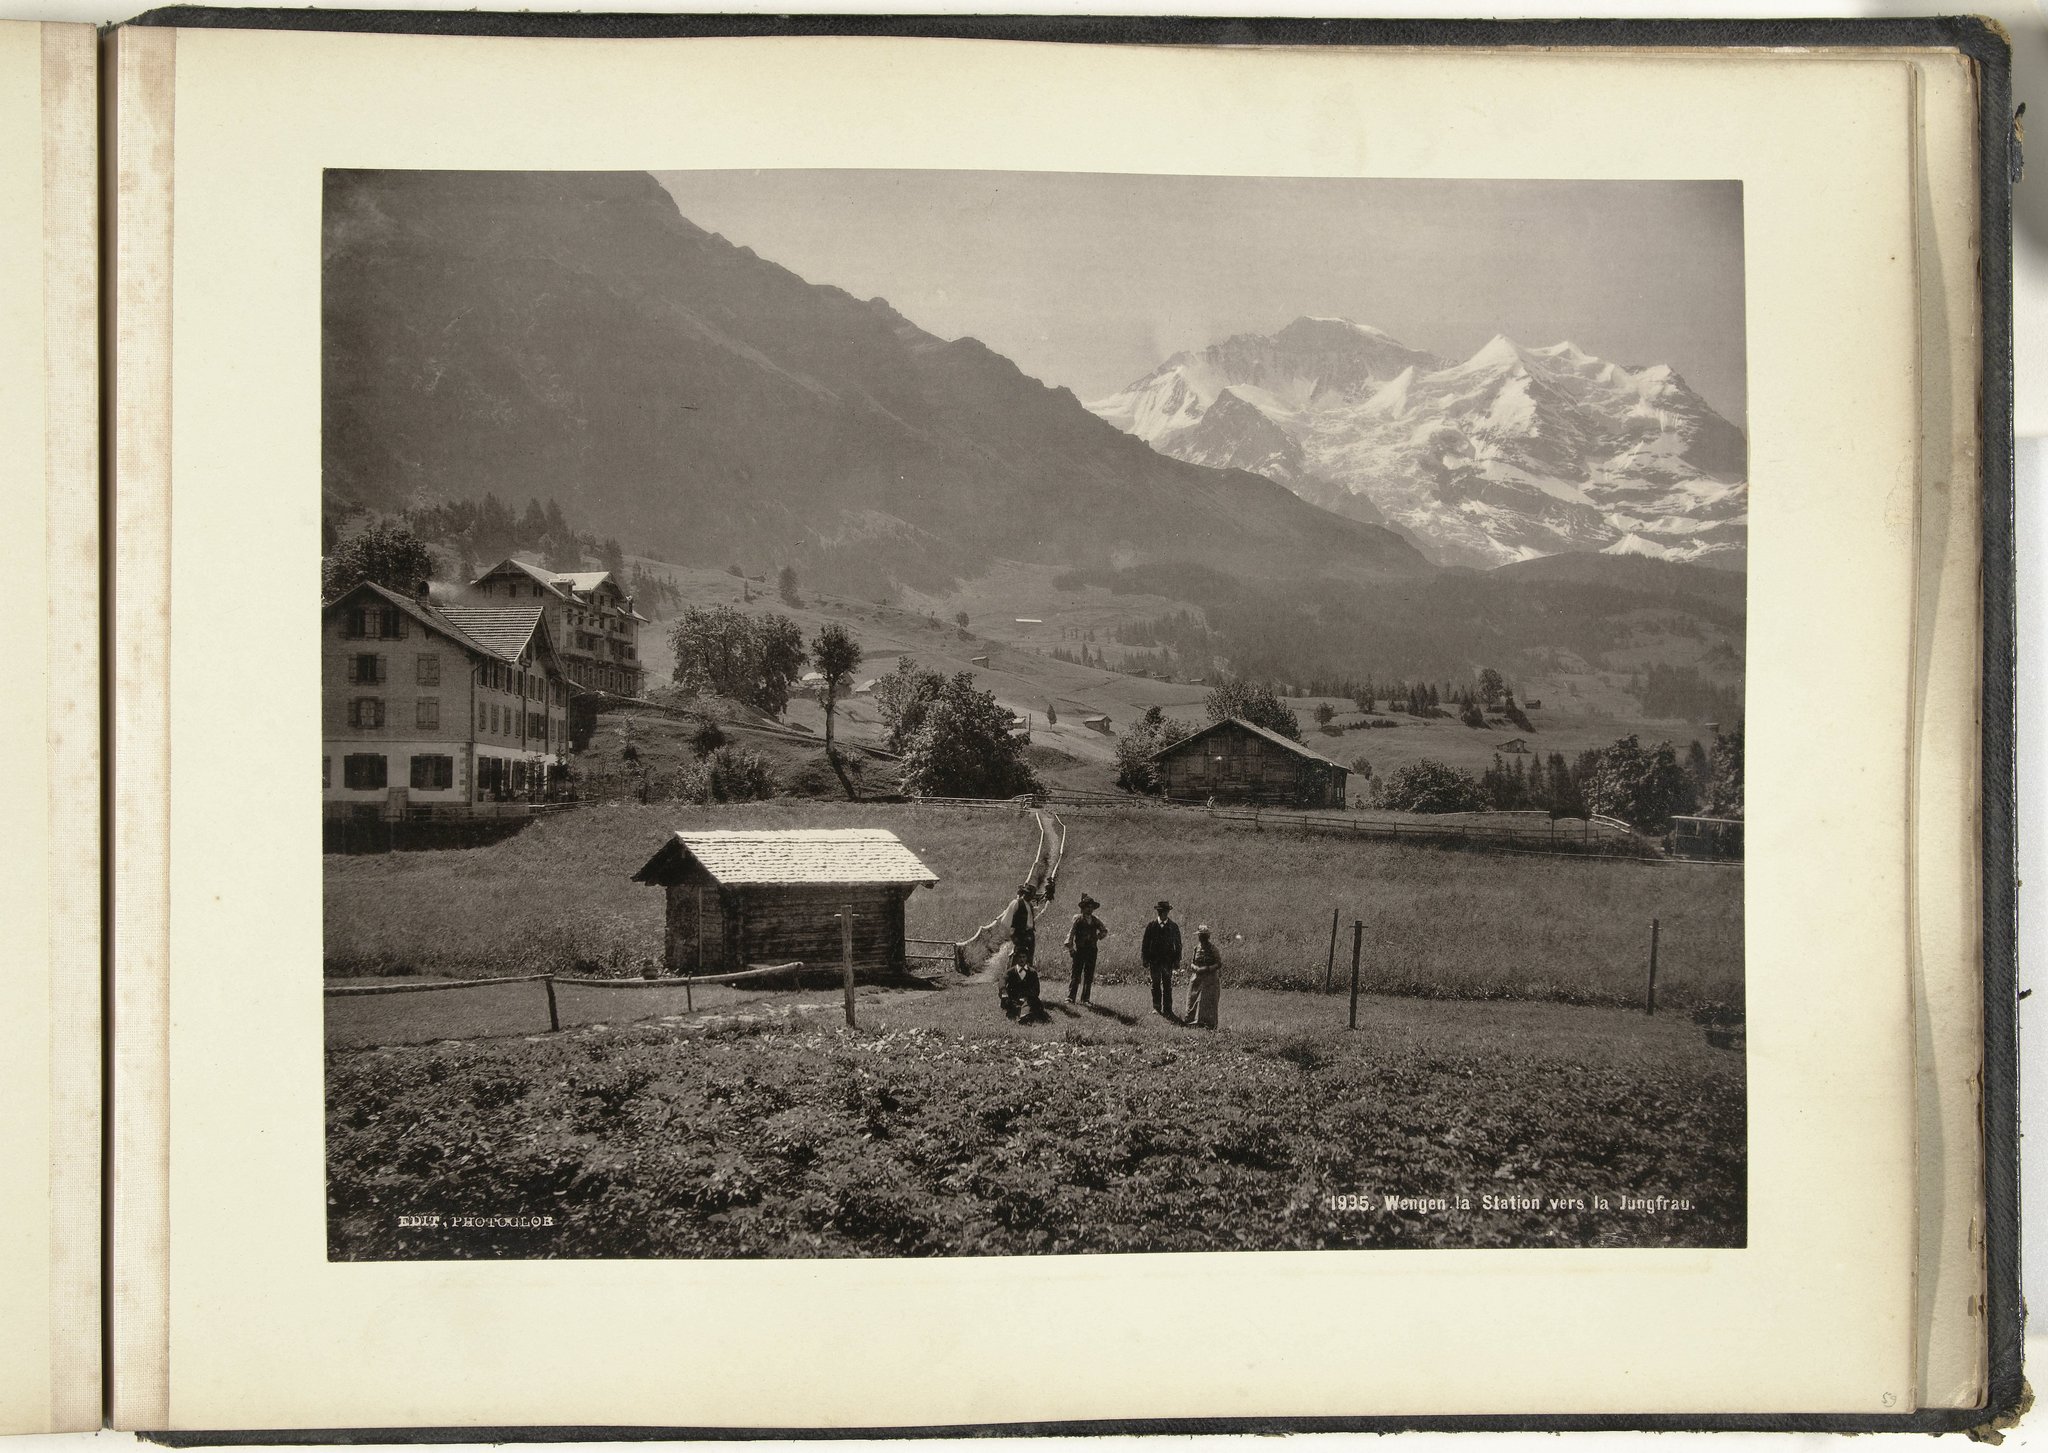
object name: photomechanical print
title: Wengen la station vers la Jungfrau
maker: Anonymous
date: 1895-1910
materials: paper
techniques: photograph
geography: zurich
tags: village, dale, valley (+ landscape with figures, staffage), mountains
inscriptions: number: ‘1995.’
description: Deze prent maakt deel uit van een album.